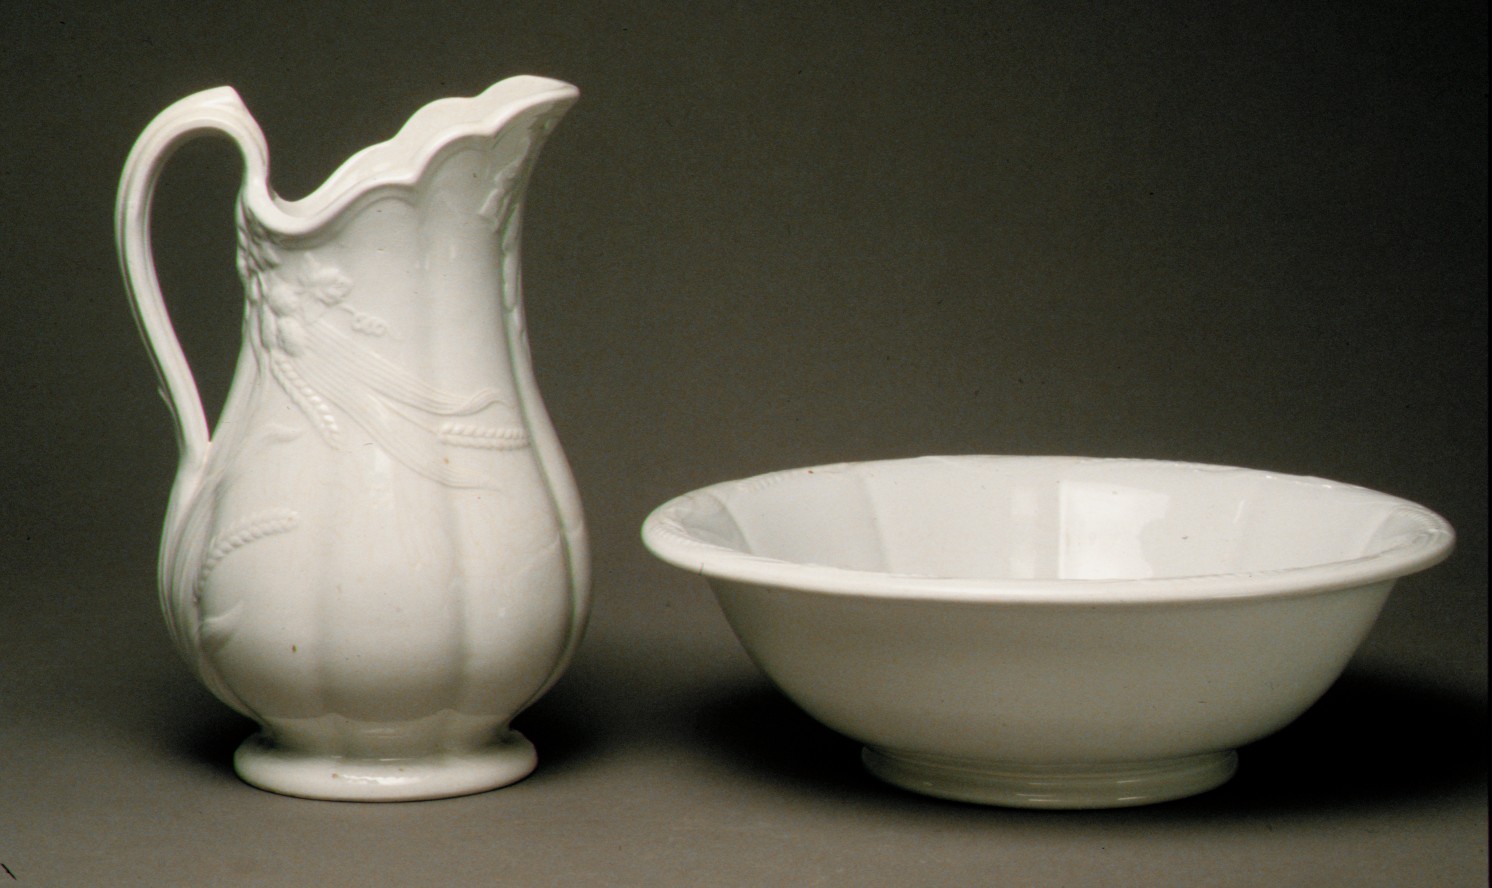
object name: pitcher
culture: british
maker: davenport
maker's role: maker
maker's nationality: british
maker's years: 1794-1887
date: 1857-1890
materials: earthenware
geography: england